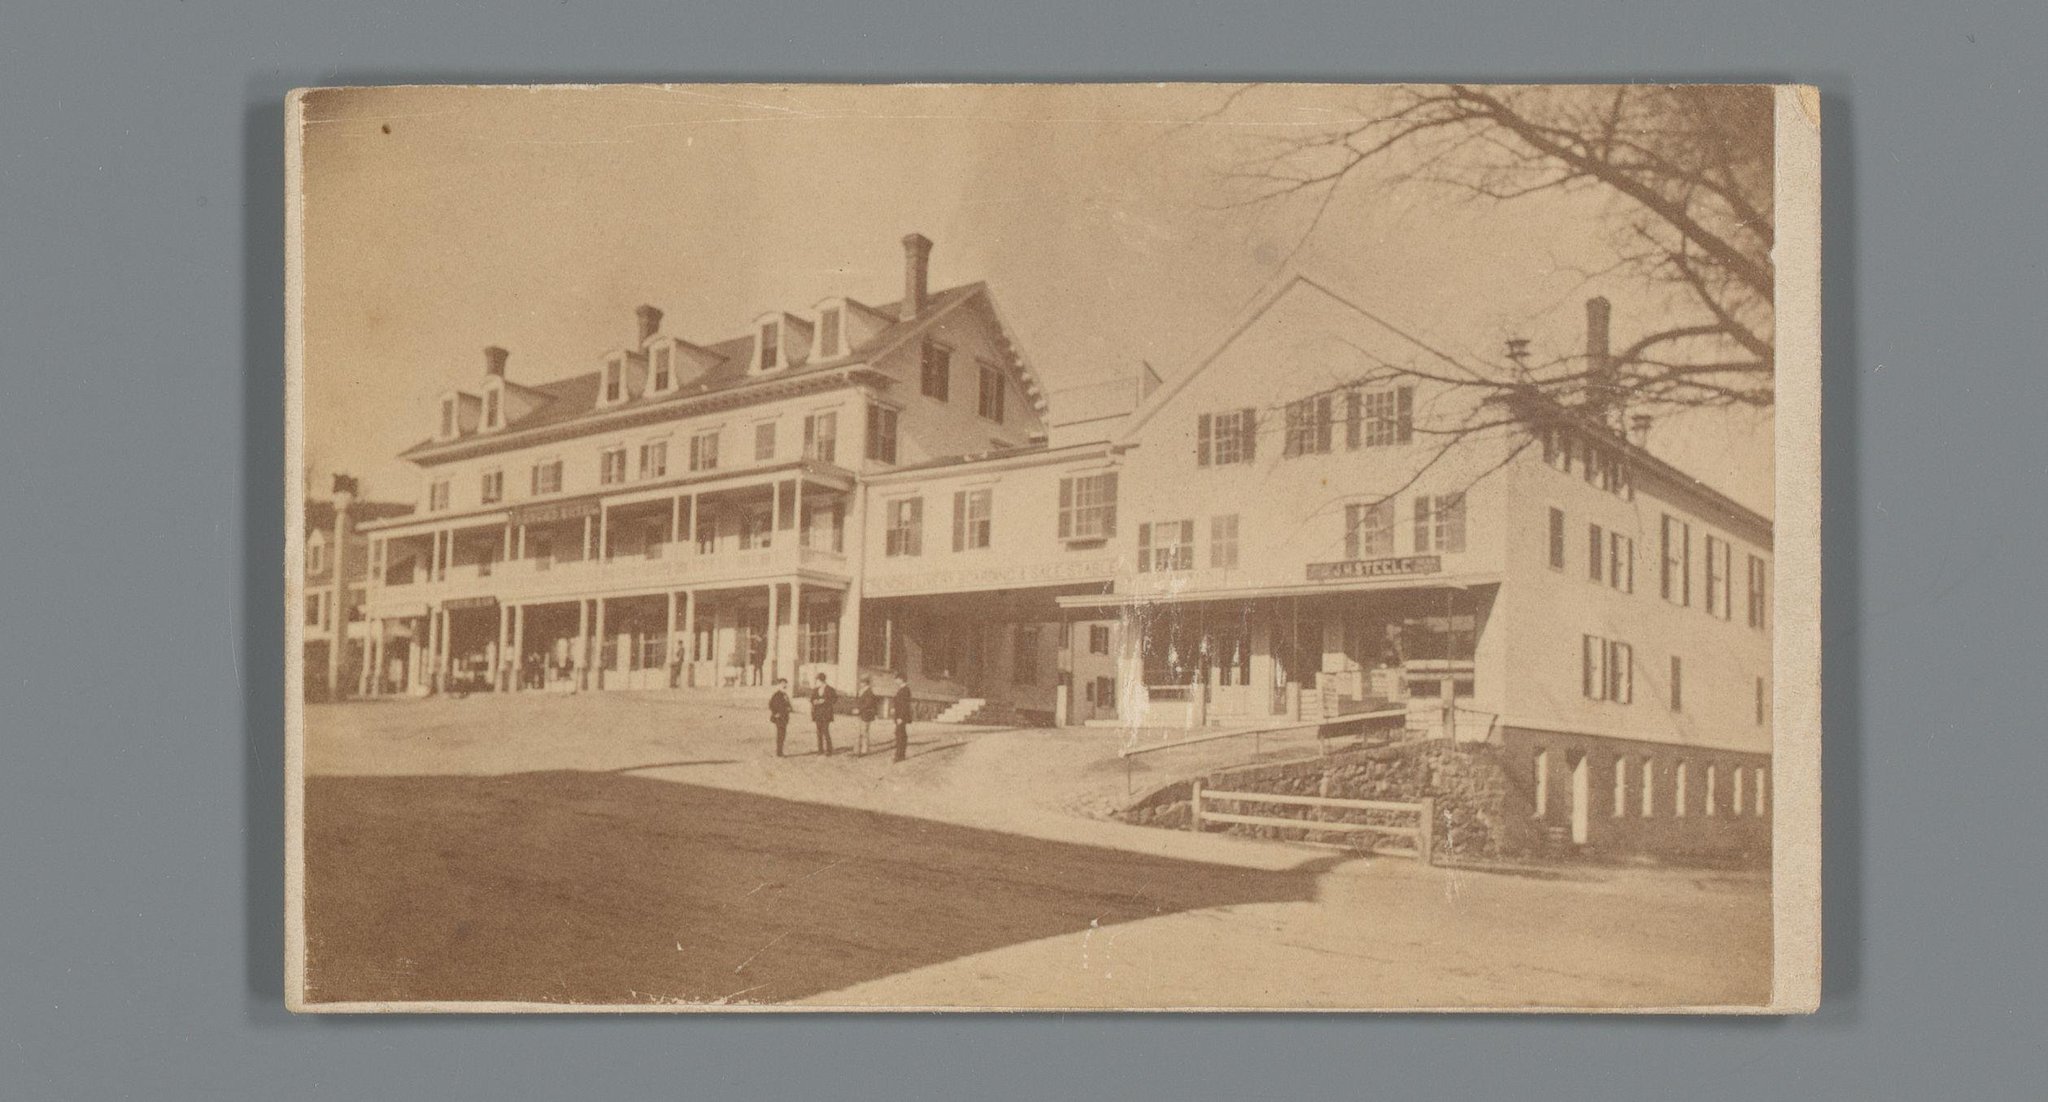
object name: photograph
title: Gezicht op voormalig Tucker's Hotel in Peterborough, New Hampshire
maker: Anonymous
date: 1850-1915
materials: cardboard, photographic support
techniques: albumen print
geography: new hampshire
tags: advertising, hotel, hostelry, inn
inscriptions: inscription: ‘(...)’